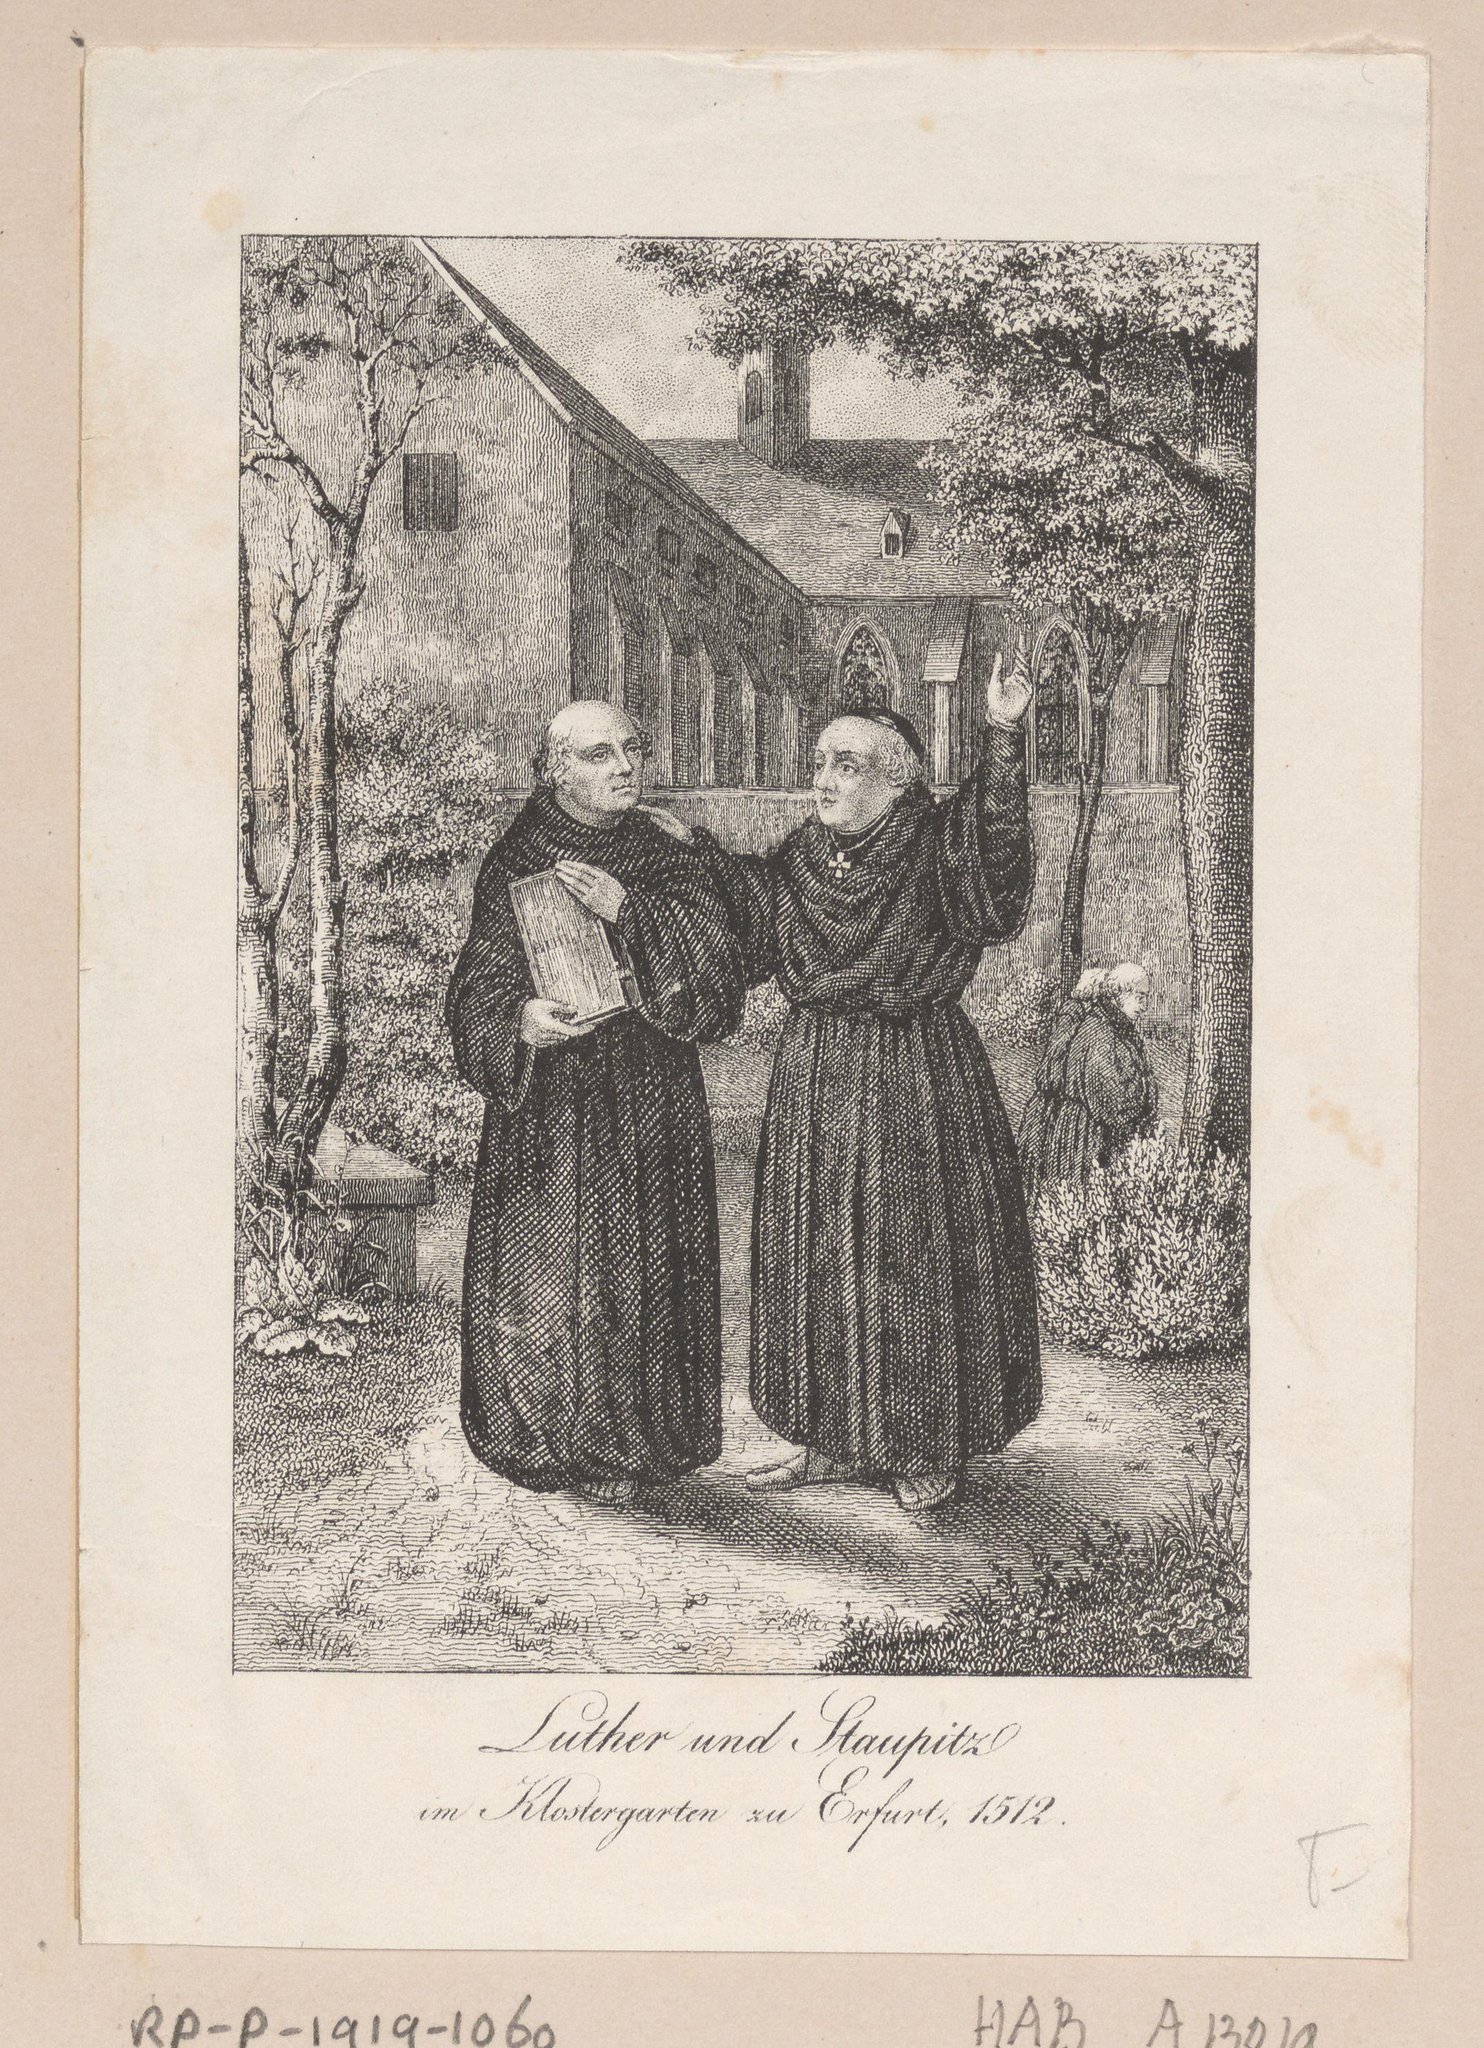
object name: print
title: Dubbelportret van Martin Luther en Johann von Staupitz in de kloostertuin van Erfurt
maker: Anonymous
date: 1800-1899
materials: paper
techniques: lithograph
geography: germany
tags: priest, martin luther, monastic orders, monastic life: augustinians, historical persons, monk(s), friar(s), abbey garden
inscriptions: collector's mark: Lugt 2228